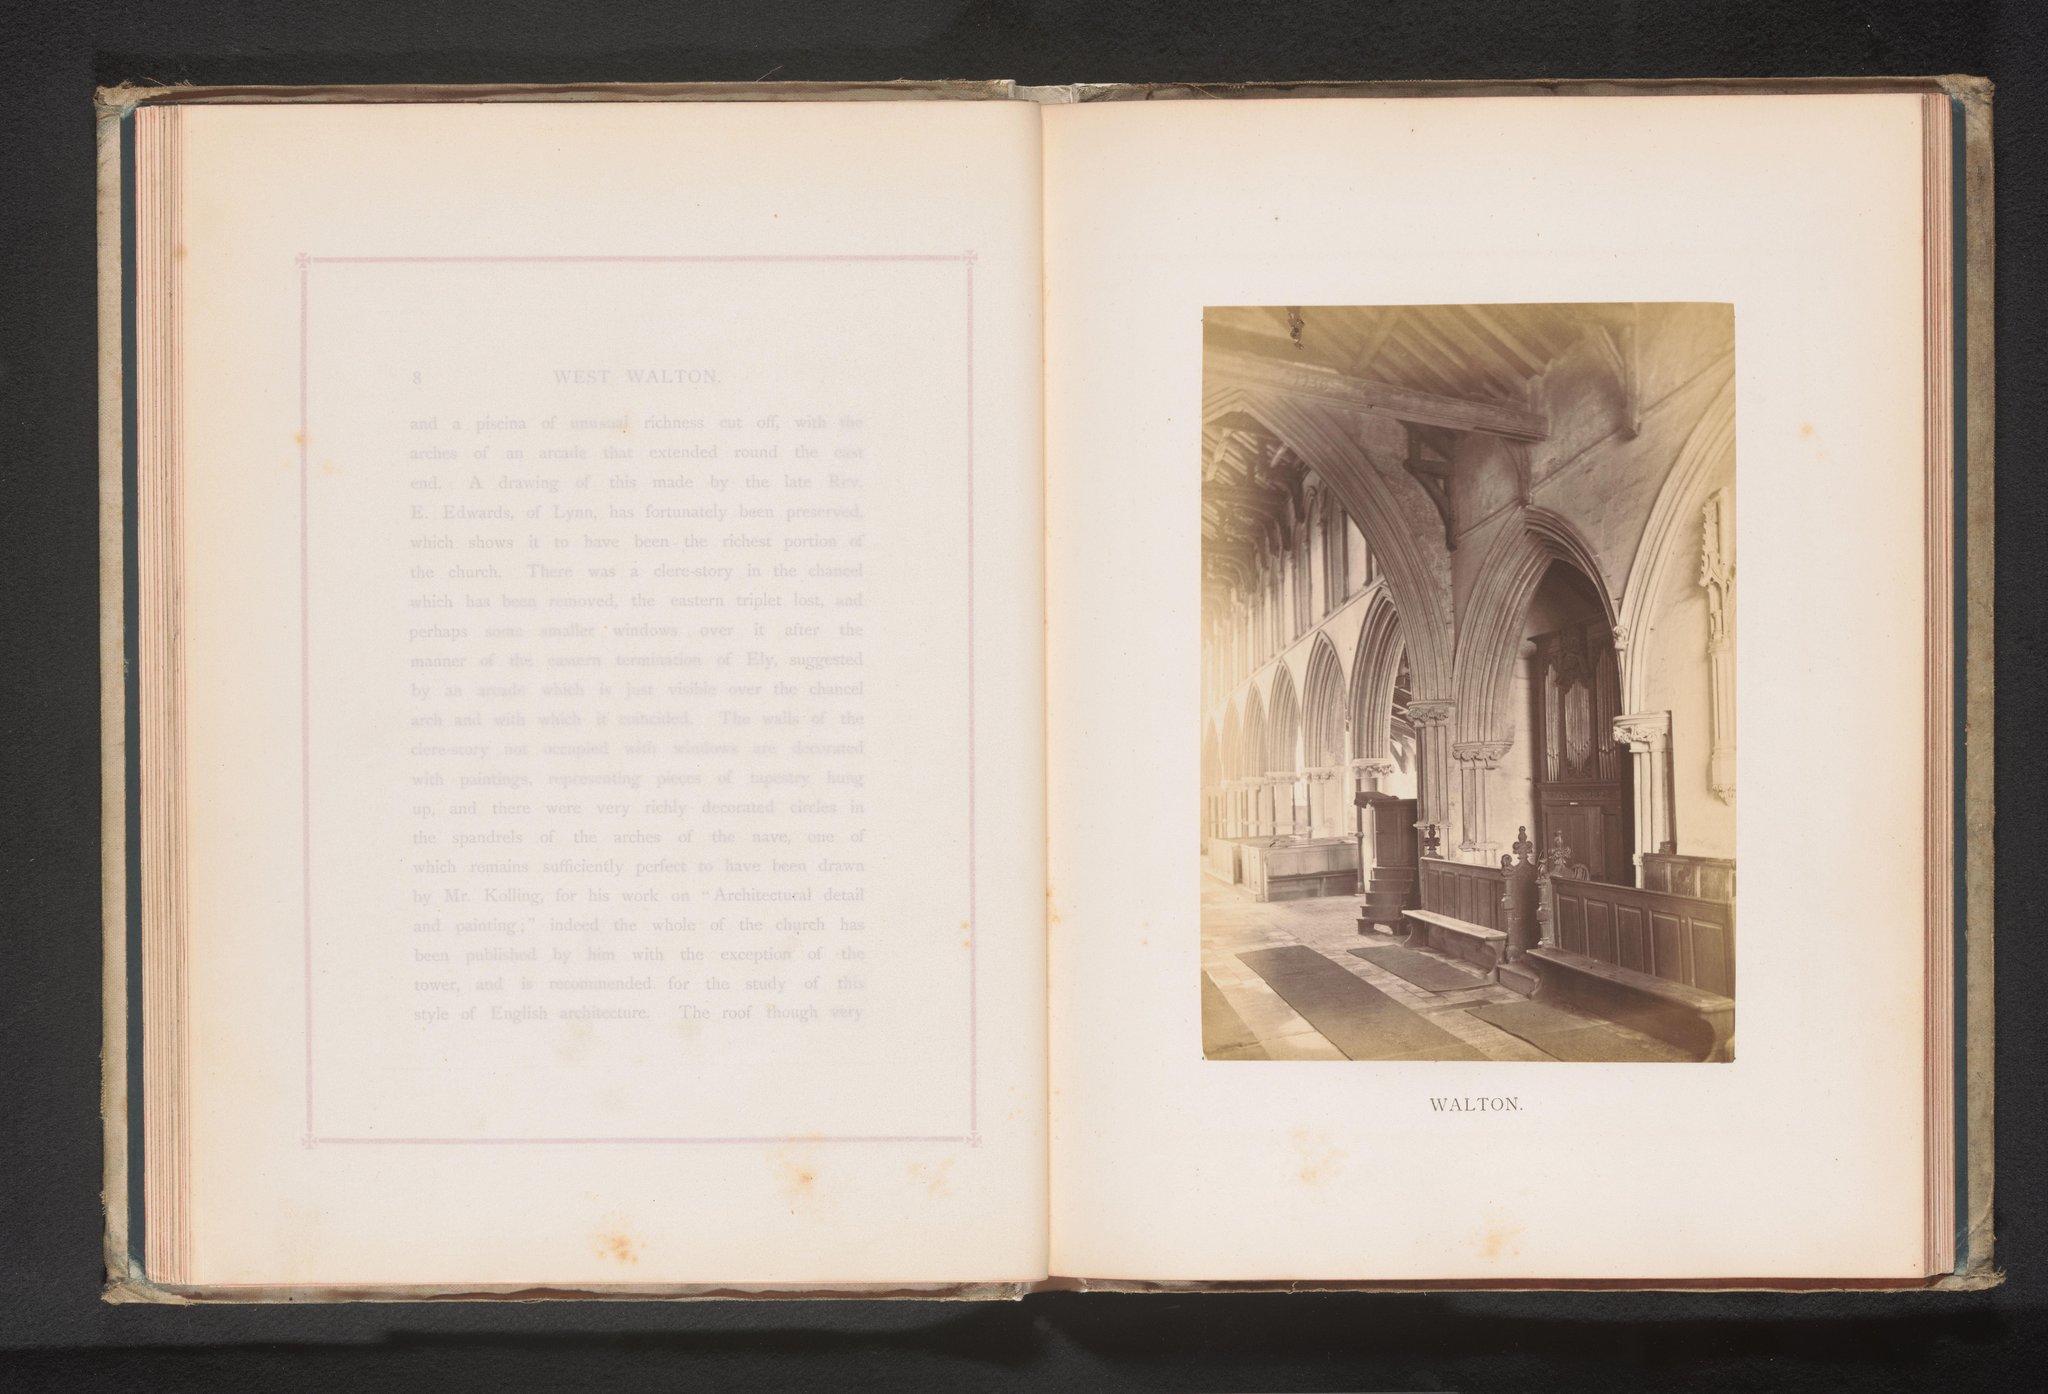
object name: page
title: Walton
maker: edward johnson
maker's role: fotograaf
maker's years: 1822-1907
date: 1858-1869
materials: photographic support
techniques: albumen print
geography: saint mary's church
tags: interior of church